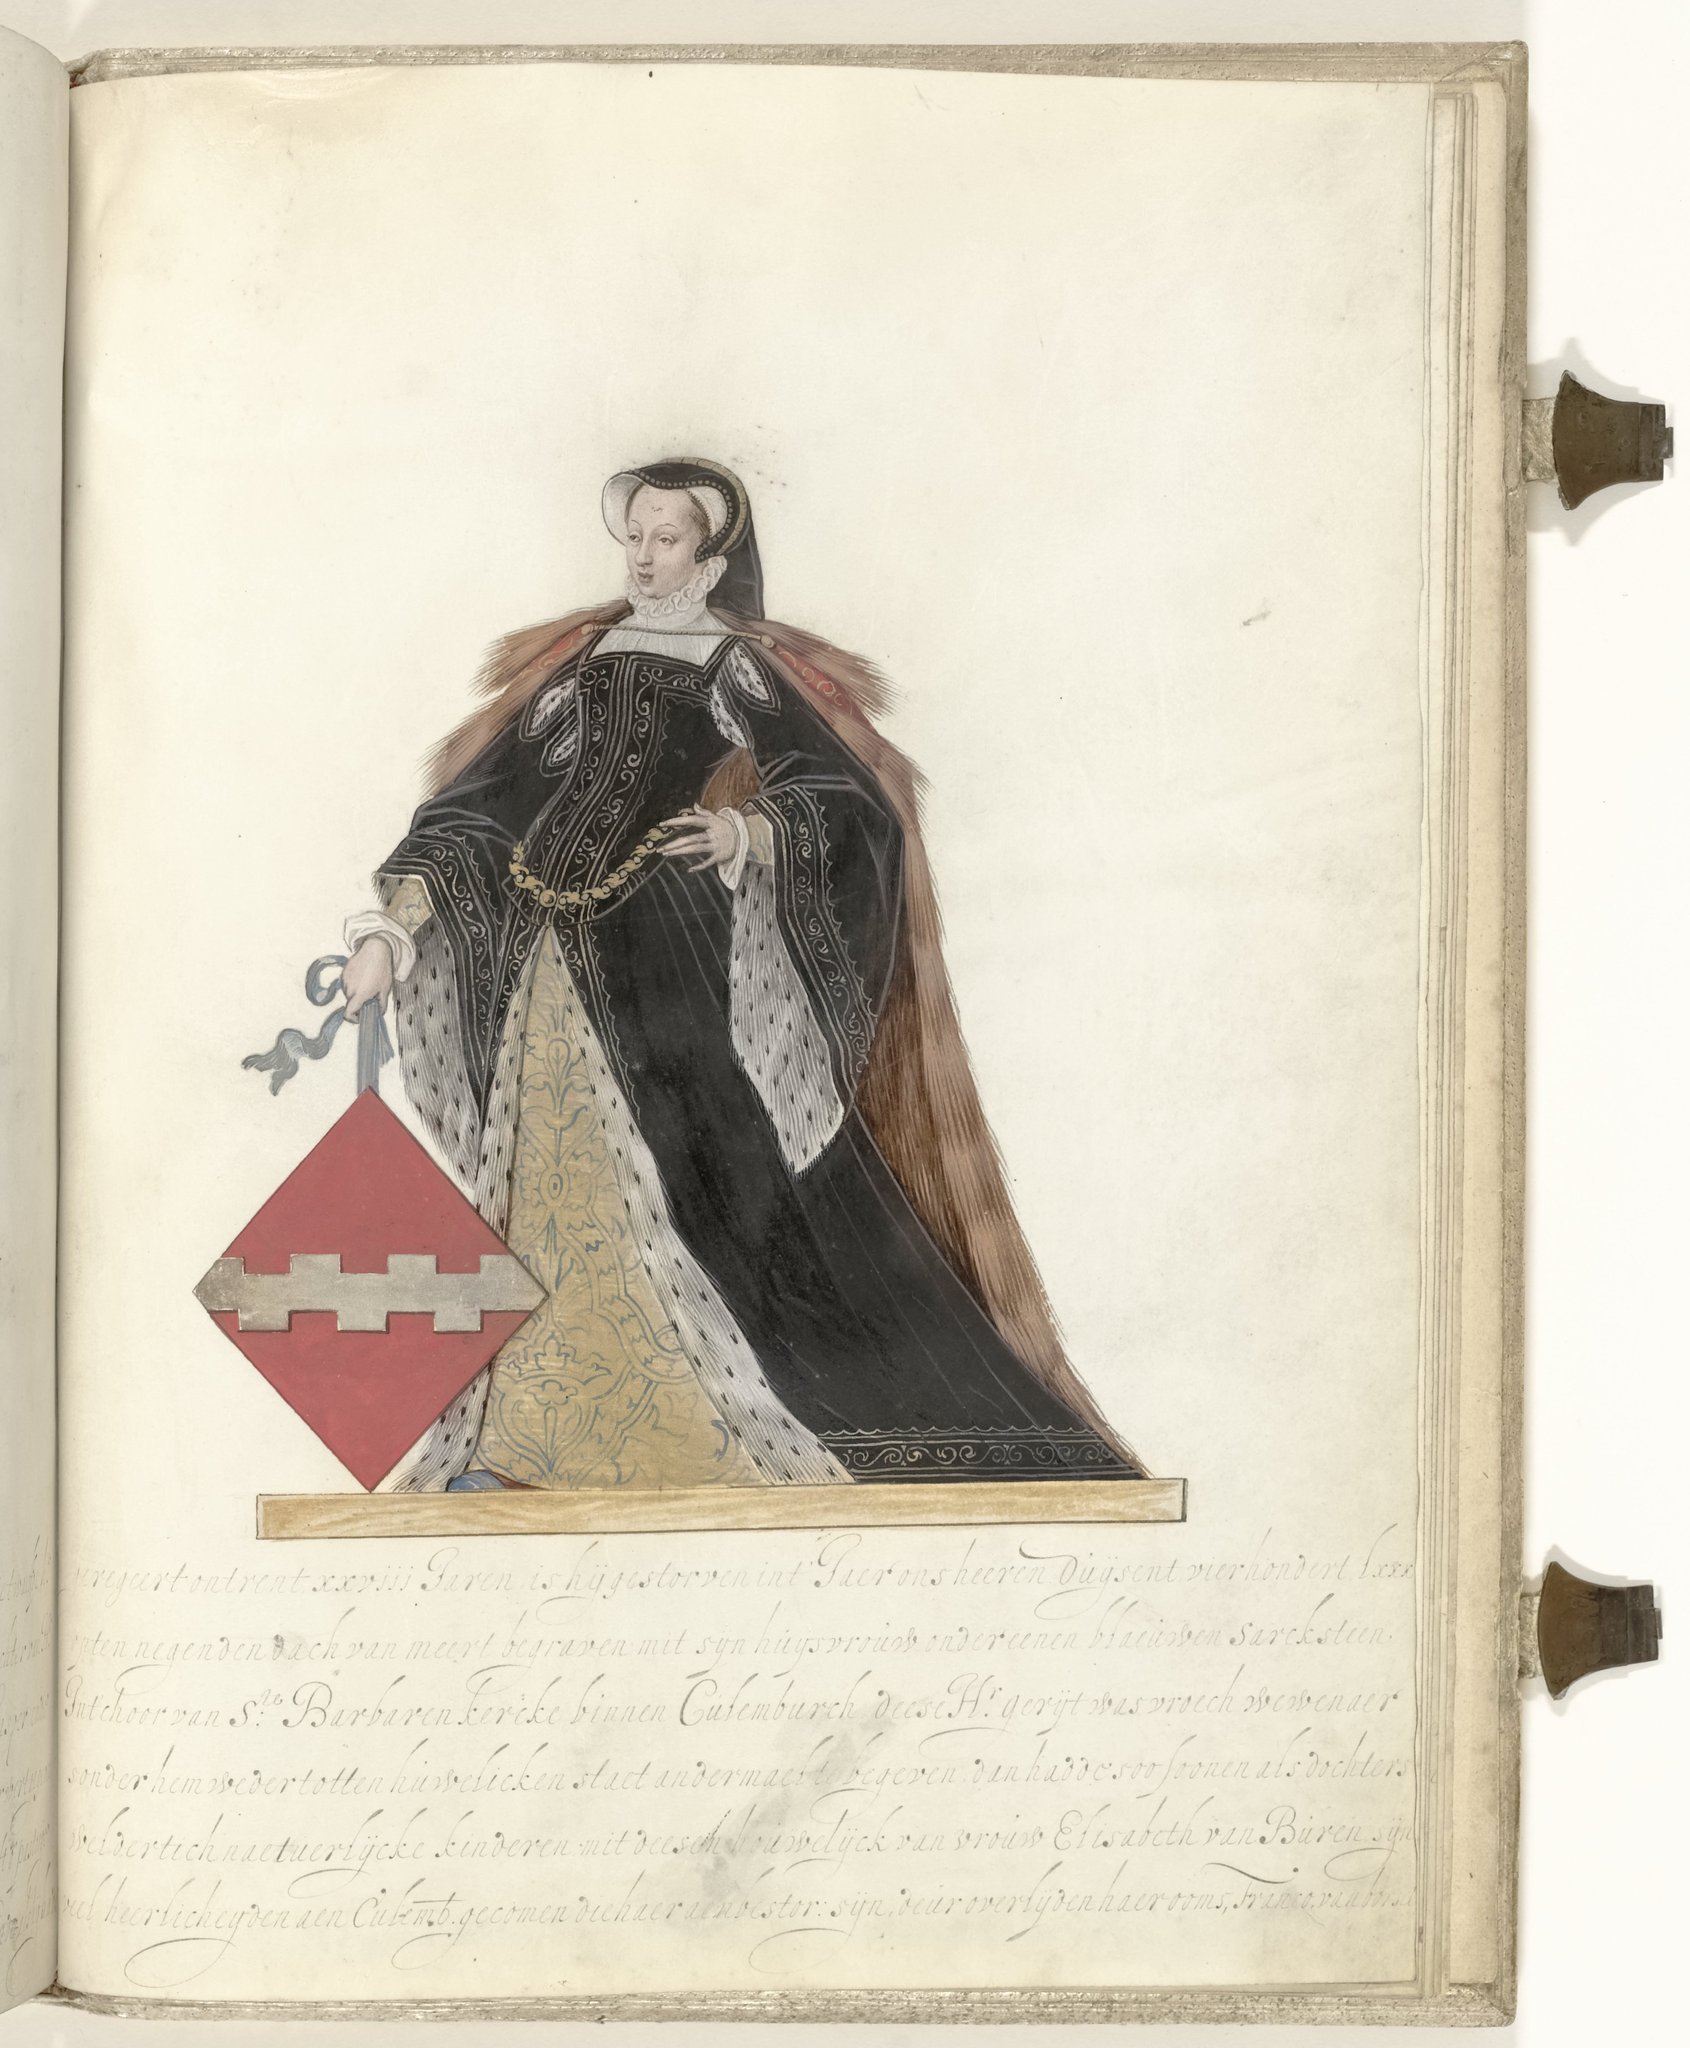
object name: drawing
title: Elisabeth van Buren, vrouwe van Culemborg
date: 1590-1593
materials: paint, gouache, ink, parchment, watercolor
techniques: writing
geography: northern netherlands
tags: culemborg, heren en graven van, elisabeth van buren vrouwe van culemborg, culemborg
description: Elisabeth van Buren, vrouwe van Culemborg. Echtgenote van Gerrit II heer van Culemborg. Staande ten voeten uit met het wapen van Buren. Onderdeel van een geïllustreerd handschrift met de genealogie van de heren en graven van Culemborg.